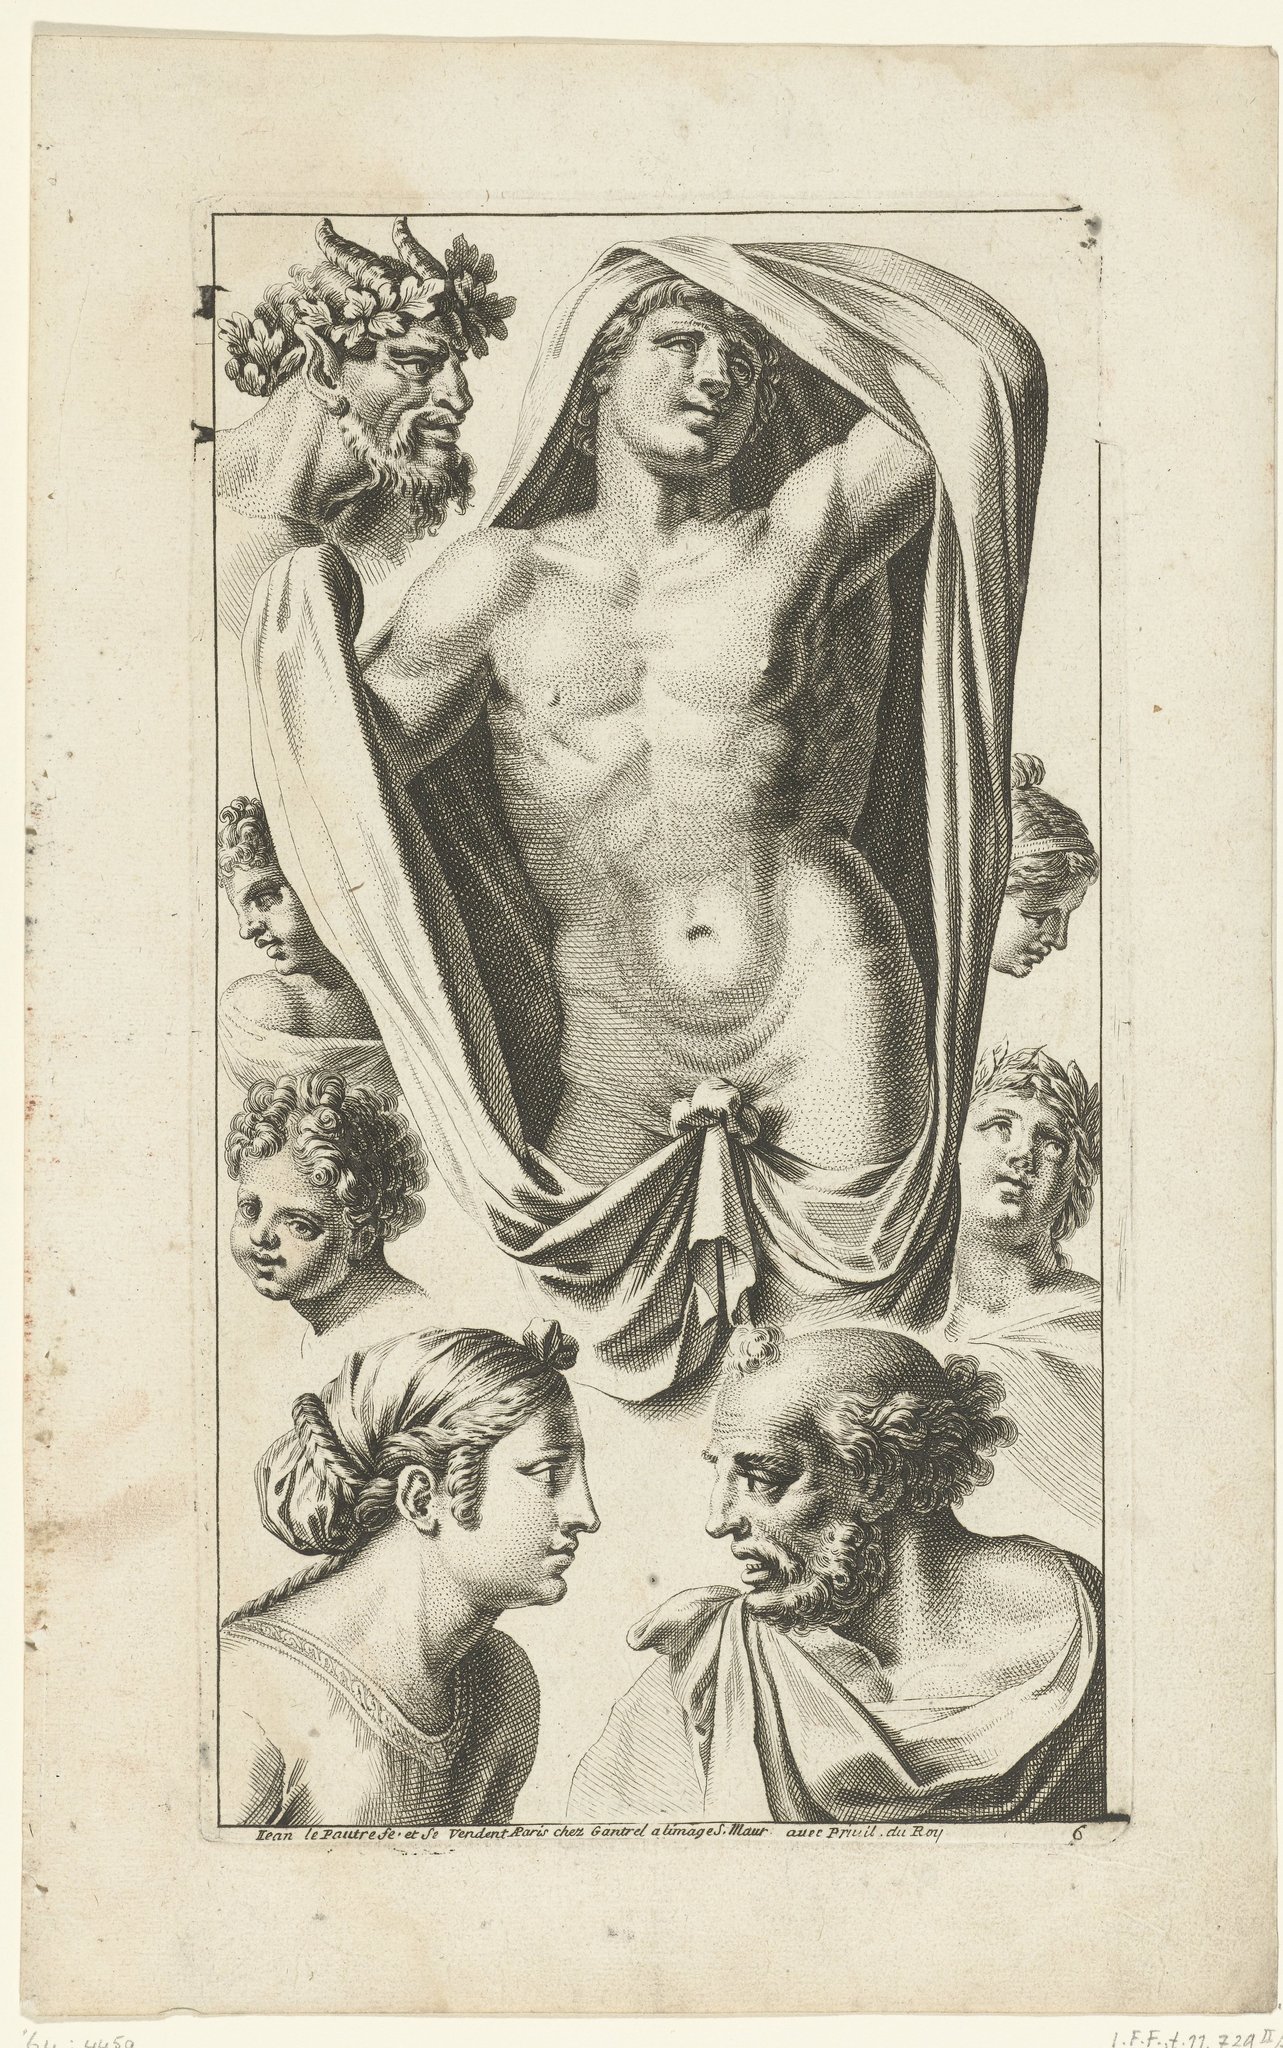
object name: ornament print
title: Academische studies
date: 1682-1706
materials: paper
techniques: engraving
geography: paris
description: In het midden staat een jongeman, in de hoek linksboven het hoofd van een sater. Uit tweede editie.